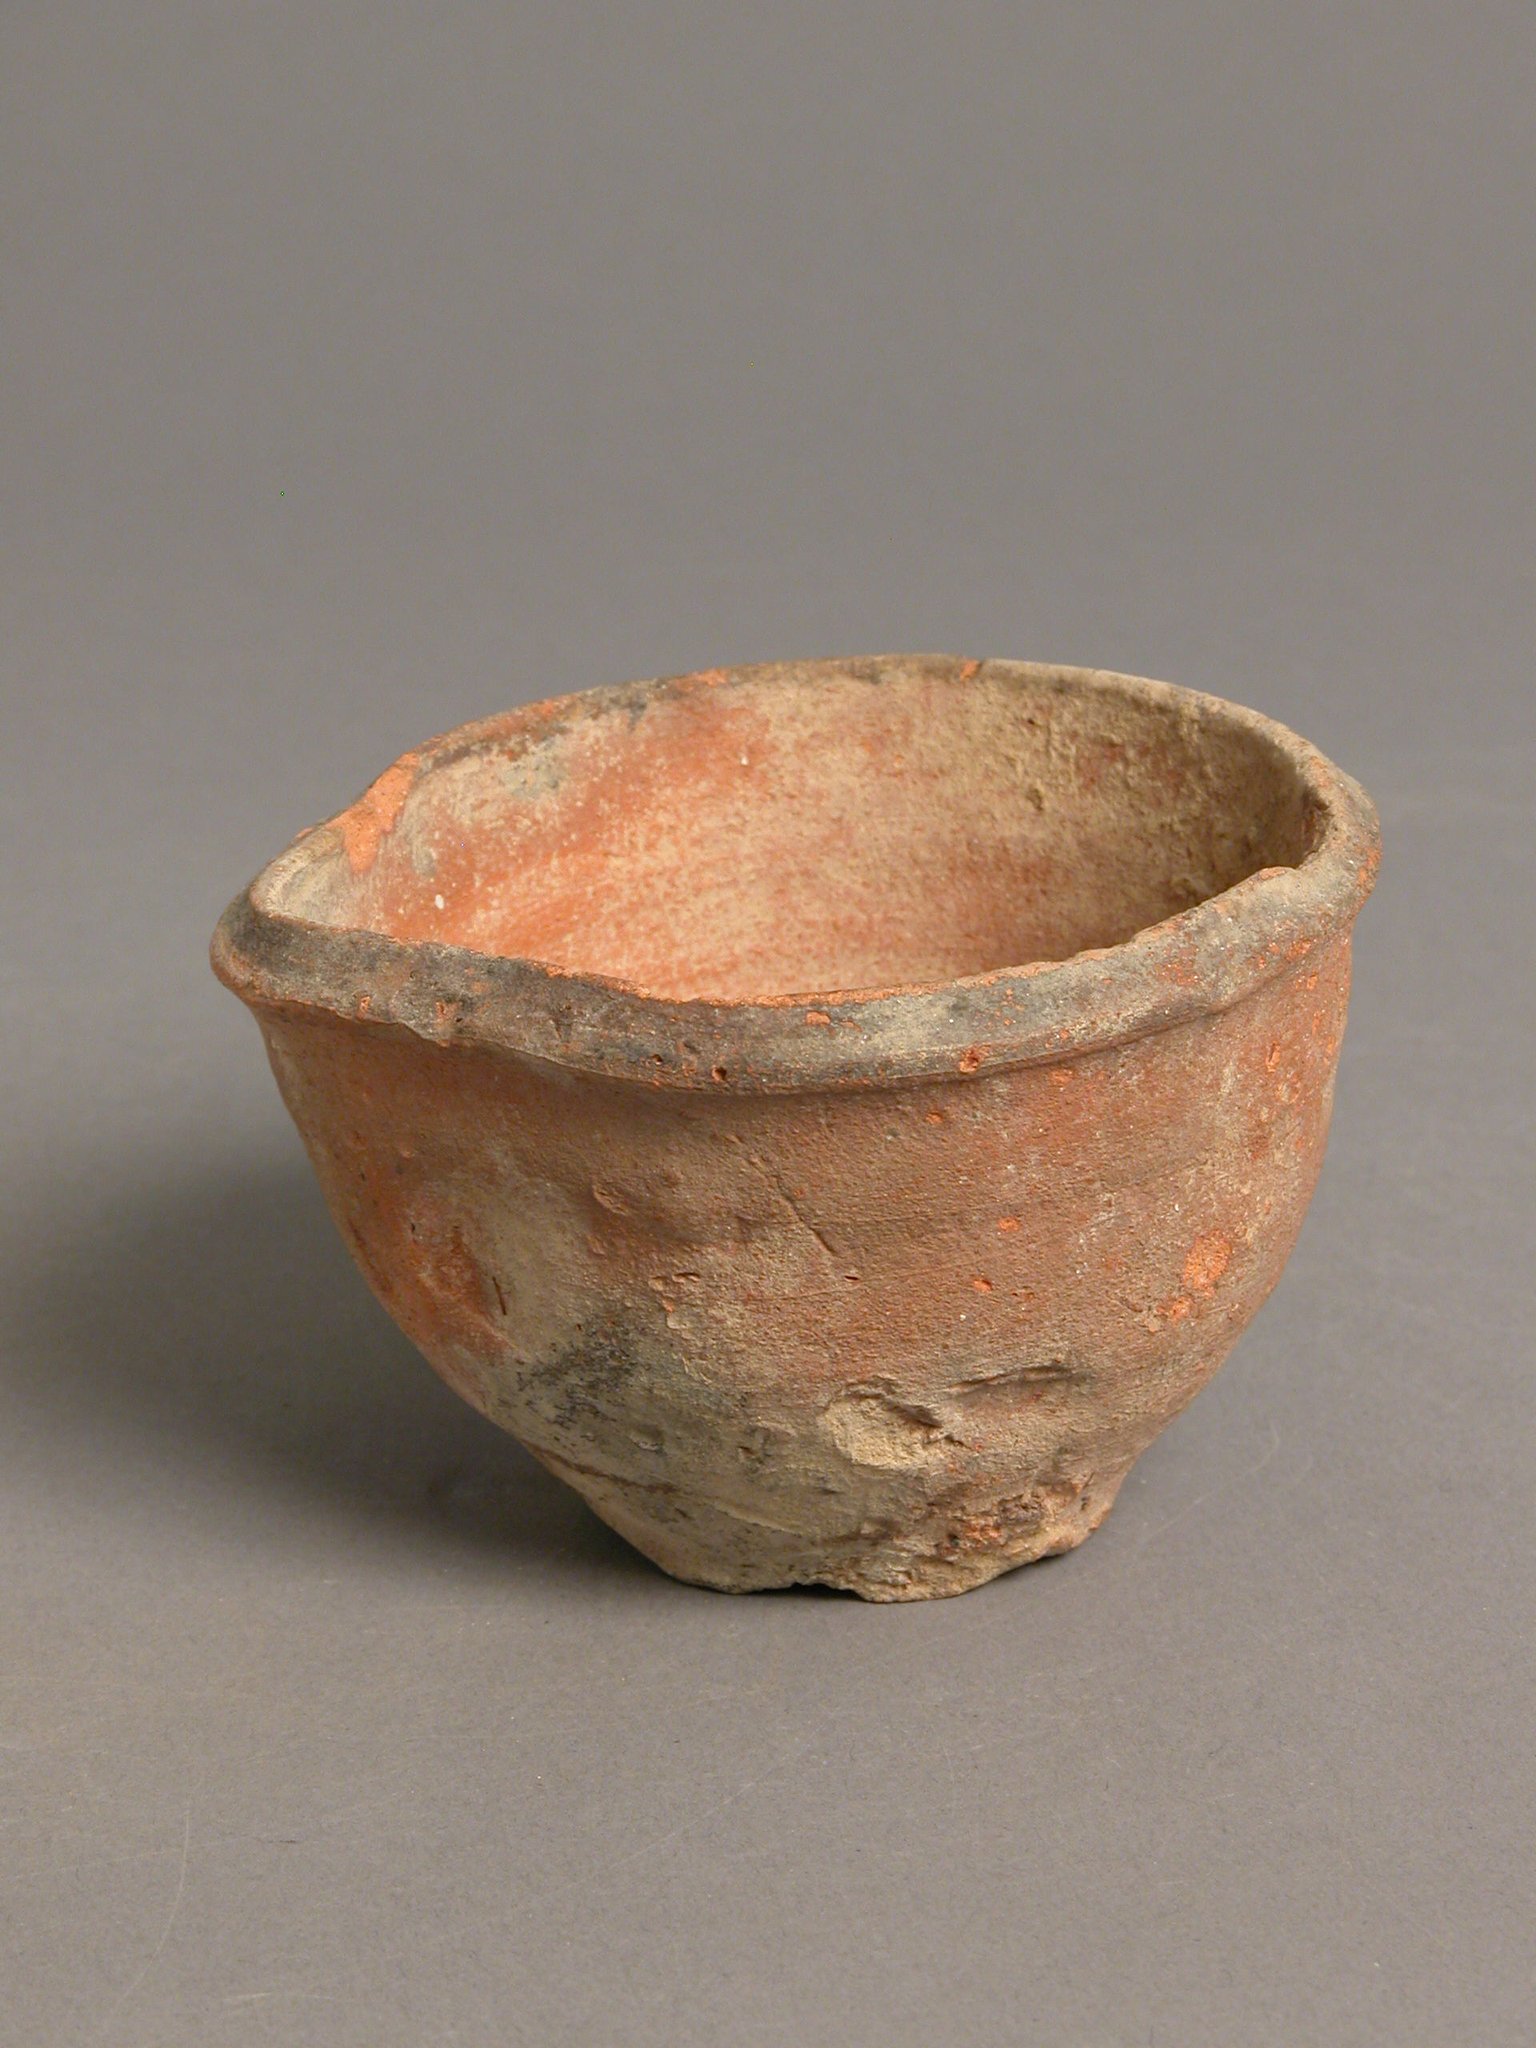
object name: cup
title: Cup with Spout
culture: coptic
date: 301-700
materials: earthenware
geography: egypt